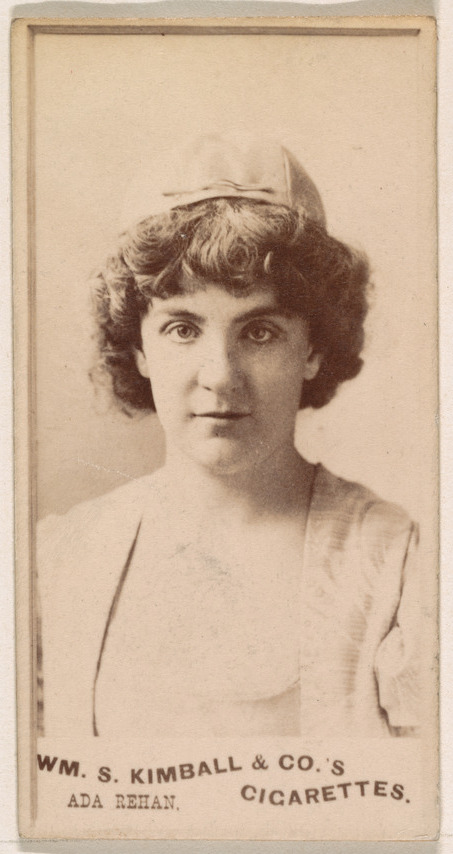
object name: photograph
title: Ada Rehan, from the Actresses series (N203) issued by Wm. S. Kimball & Co.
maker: william s. kimball & company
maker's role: publisher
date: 1889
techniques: color lithograph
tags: portraits,women,actresses